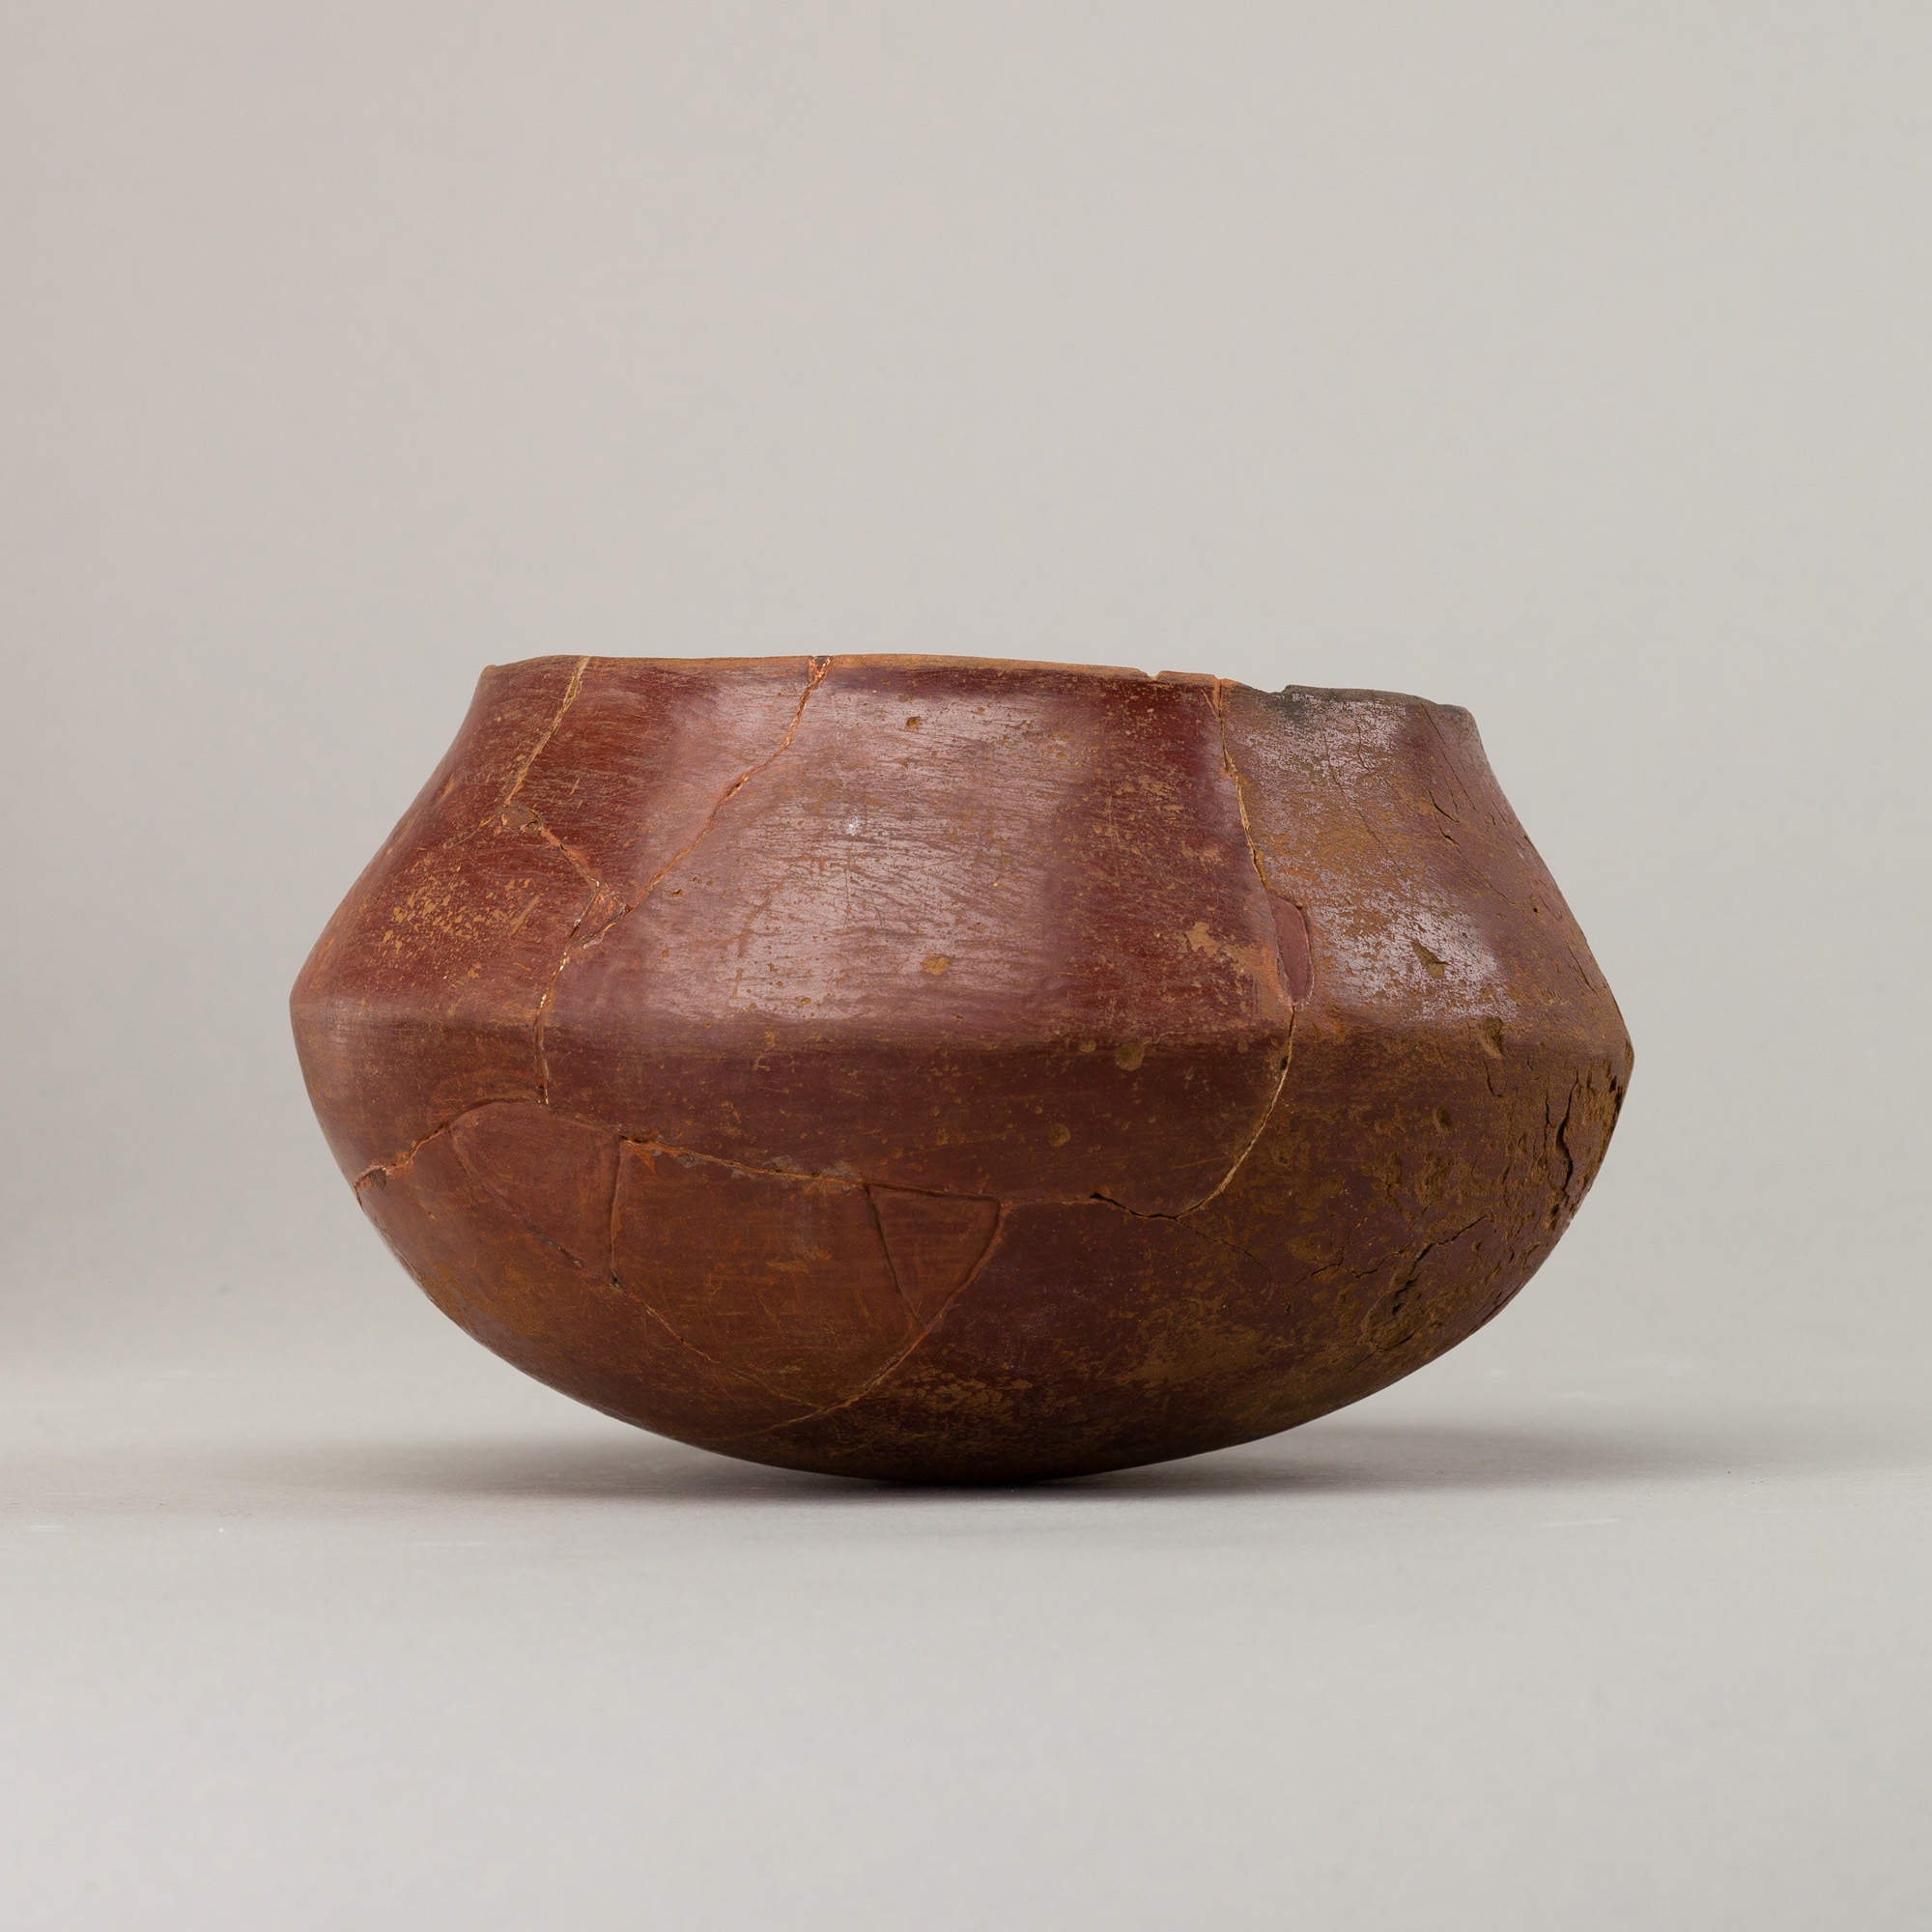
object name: bowl, red polished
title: Red polished ware bowl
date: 3850-2960 BCE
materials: pottery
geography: egypt